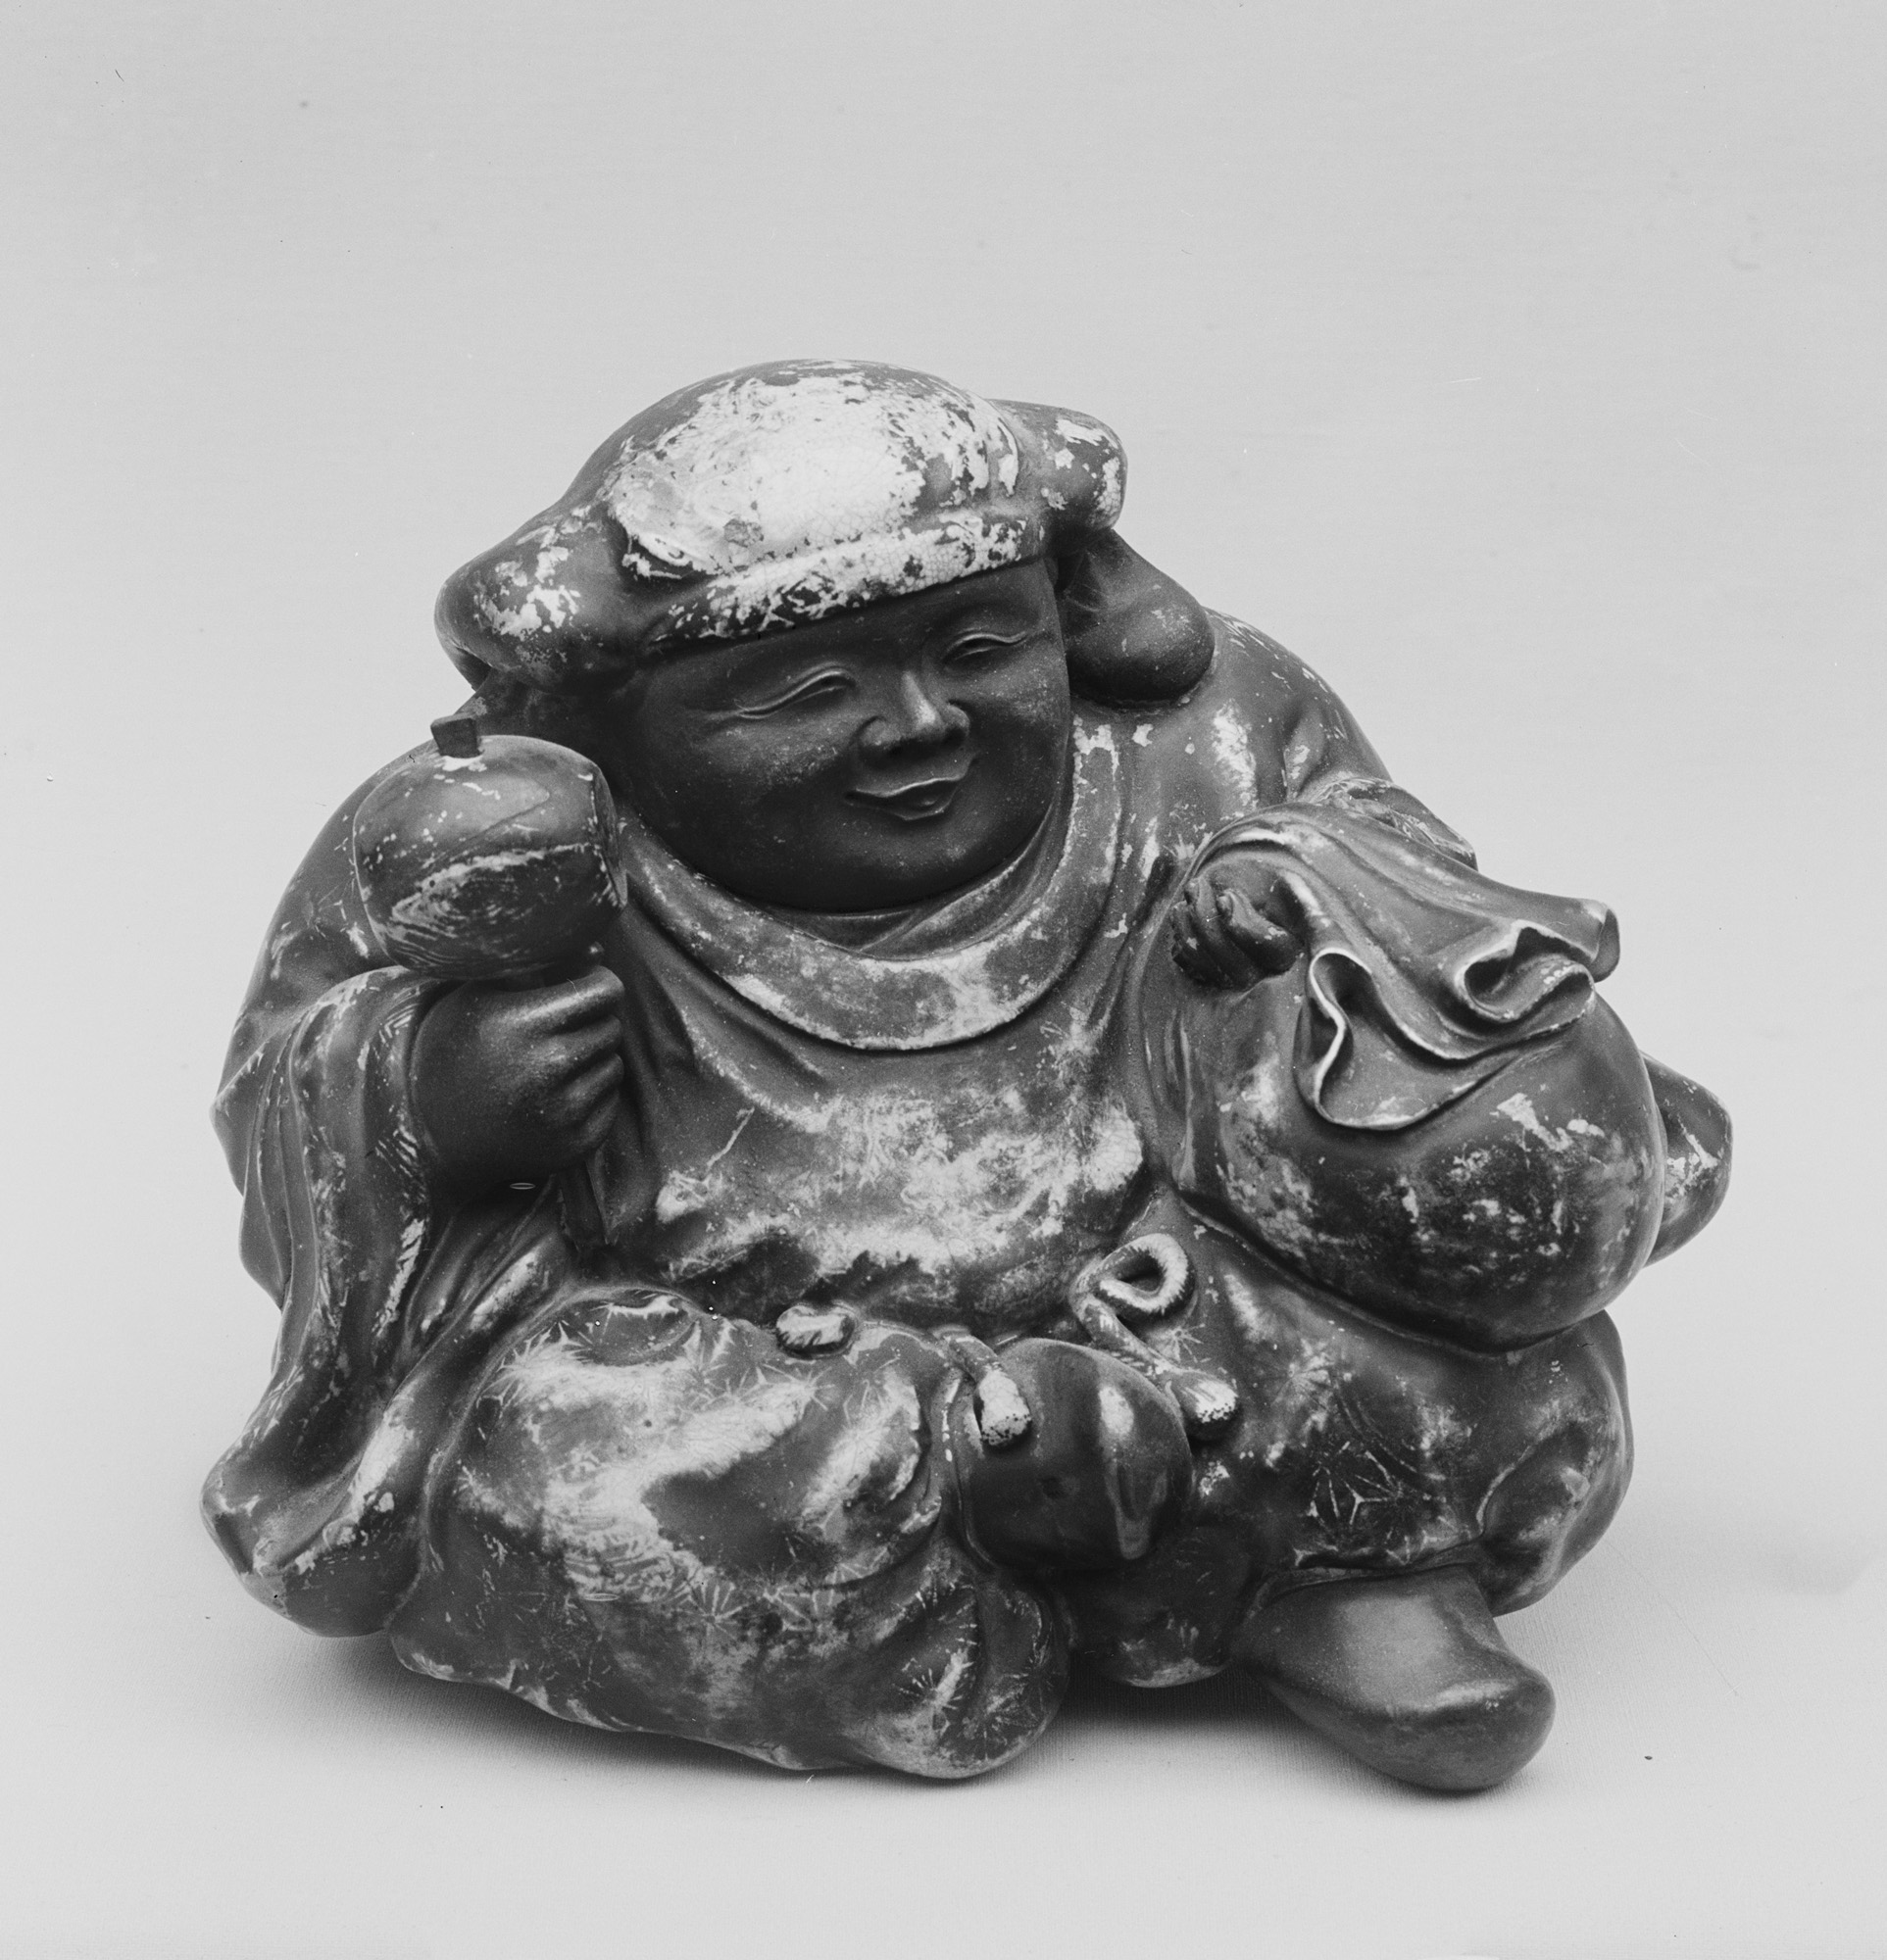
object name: ornament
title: Ornament in the shape of Daikoku, God of Luck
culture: japanese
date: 1698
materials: clay, gilt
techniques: glazing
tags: men,gods